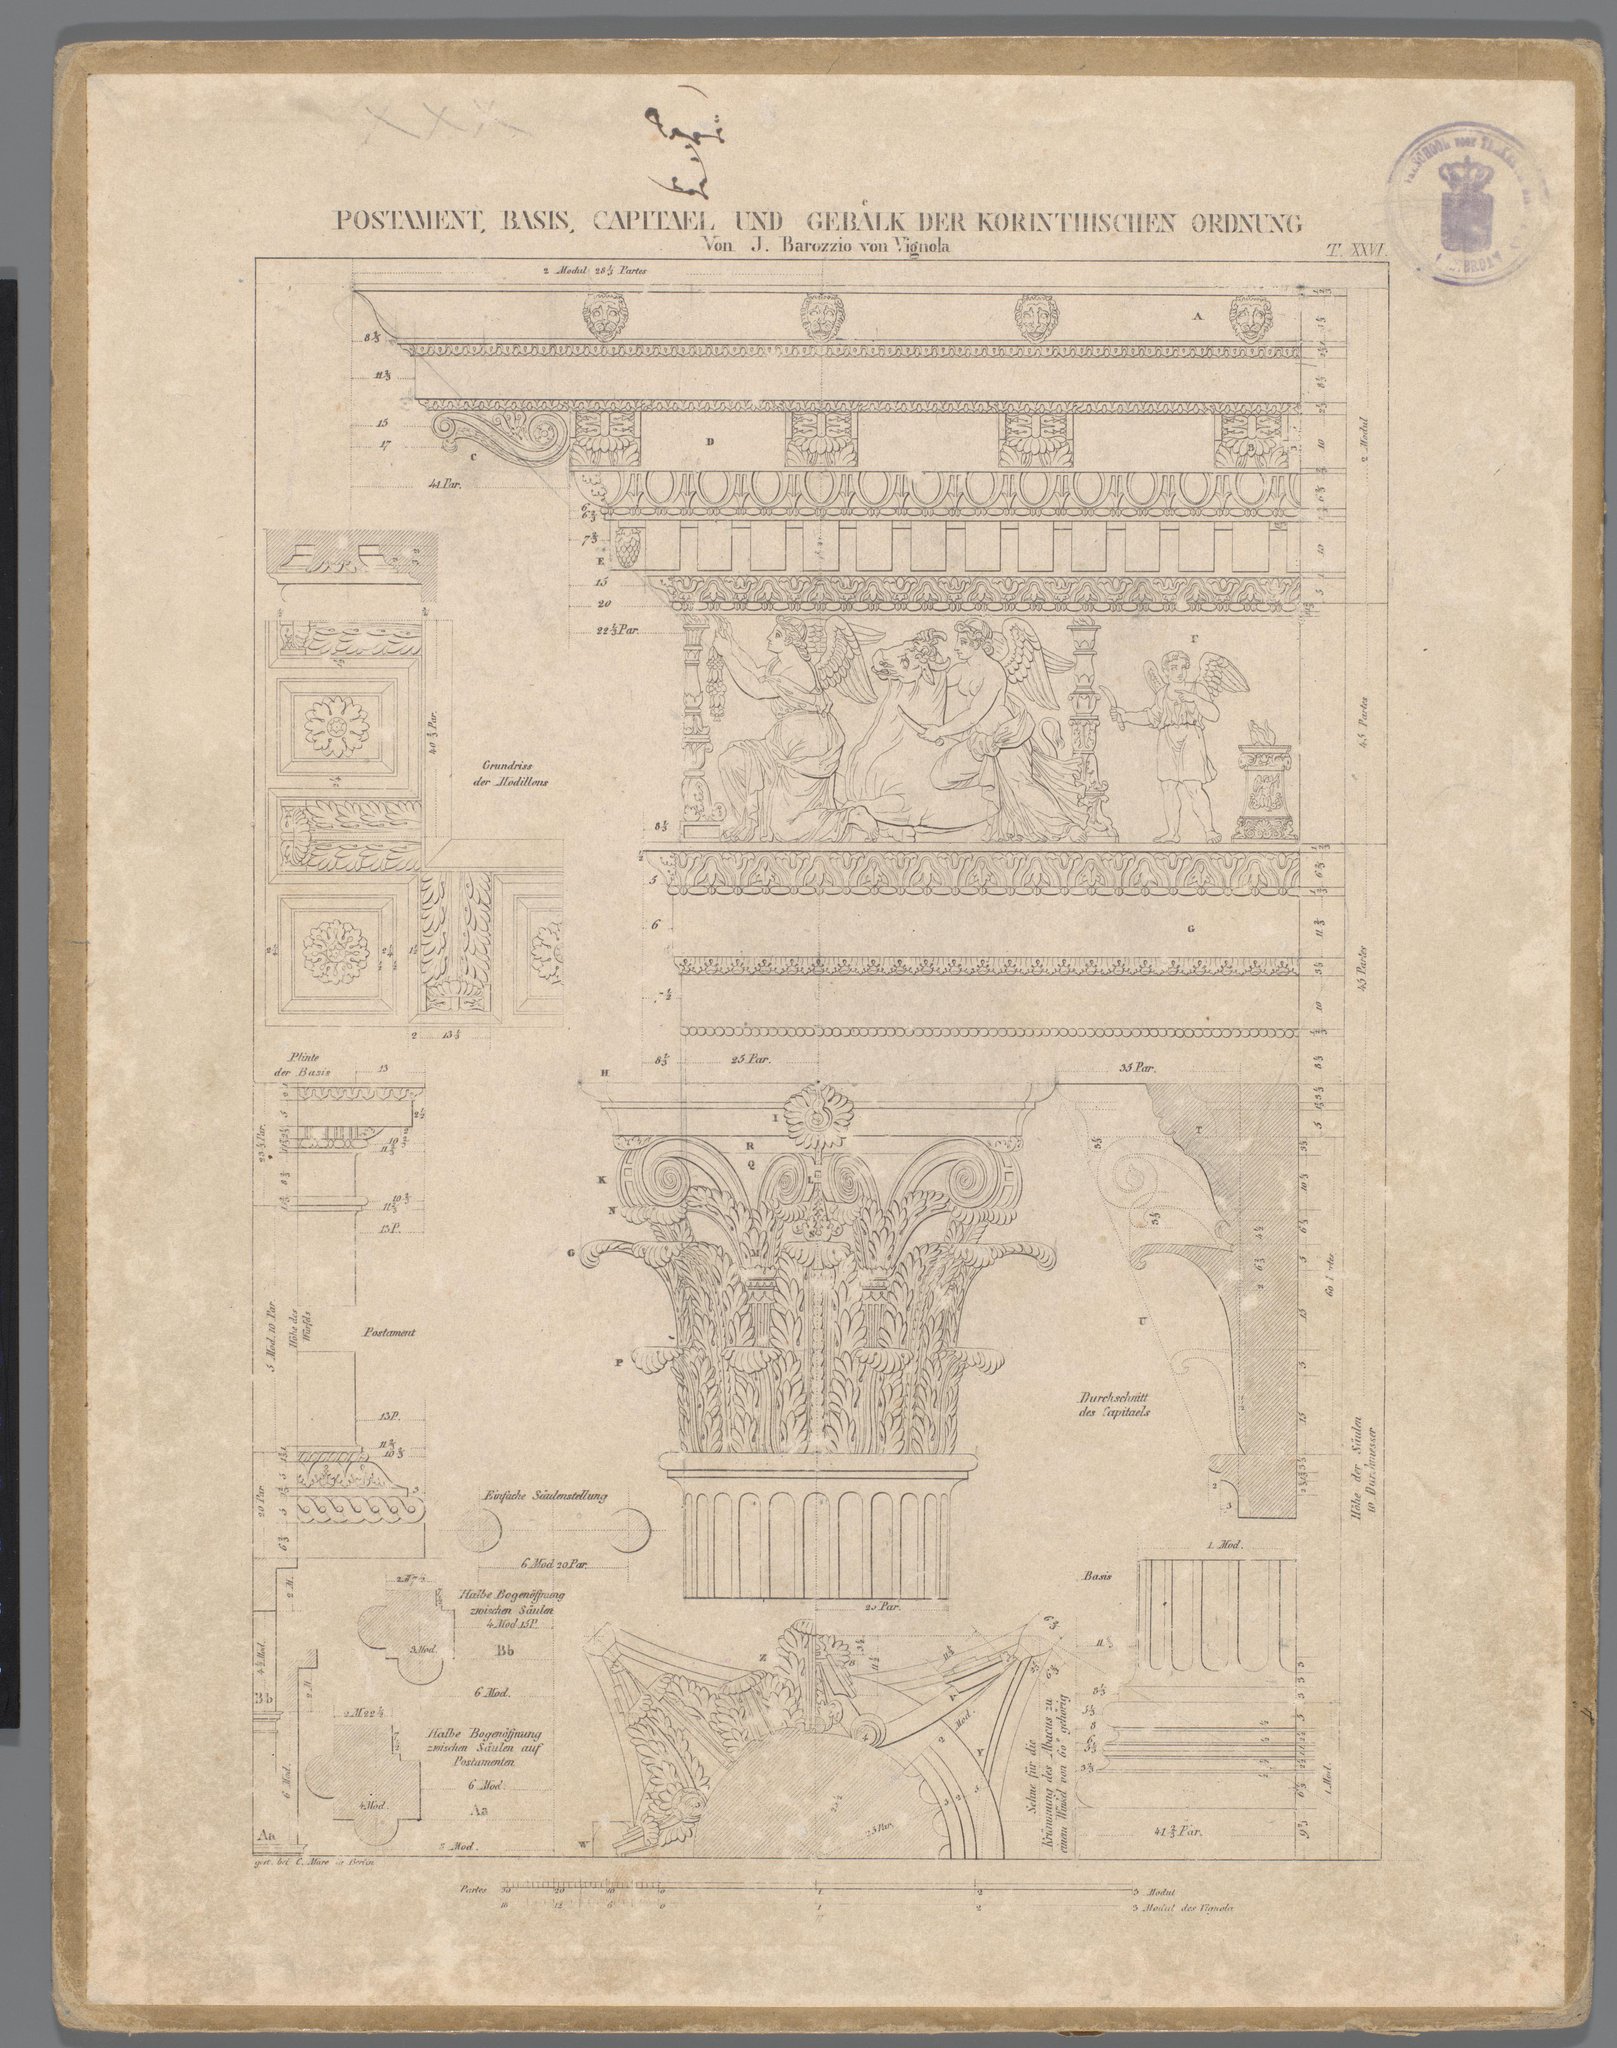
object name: photomechanical print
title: Postament, Basis, Capitael und Gebälk der Korinthischen Ordnung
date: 1855-1930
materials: paper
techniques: photolithography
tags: drawing, sketch, column, pillar ~ architecture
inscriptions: collector's mark: ‘[...]SCHOOL voor TEEKEN[...] [...]ERDAM’, annotation: ‘K. R.’